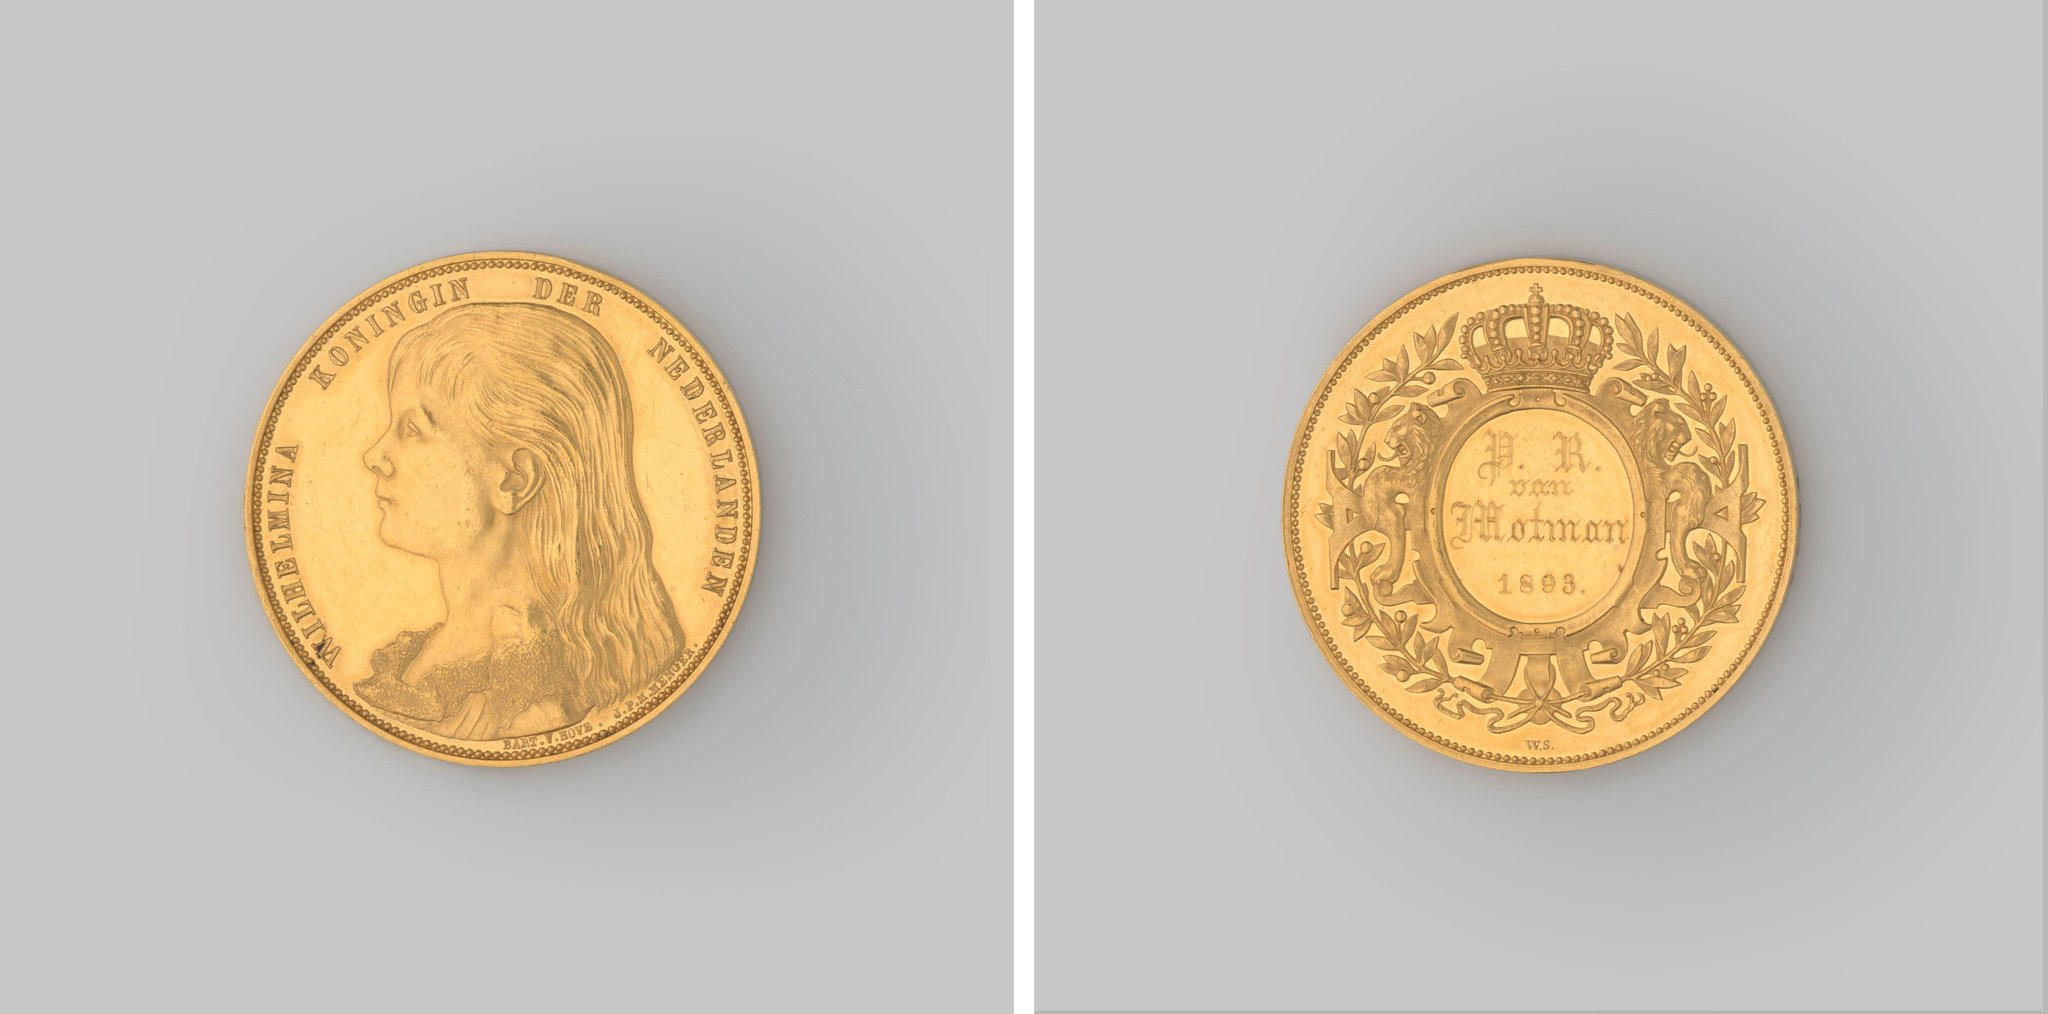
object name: medal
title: Honorary Medal of Queen Wilhelmina Awarded in 1893 to P.R. van Motman for Winning a Horse Race in Batavia, Dutch East Indies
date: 1892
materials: gold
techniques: engraving, striking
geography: netherlands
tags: the hague, print maker, wilhelmina of the netherlands, batavia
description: The Rijksmuseum’s medal collection, boasting some 12,500 objects, is almost a century and a half old. The museum continues to expand its collection with special medals, which are either purchased, donated, or given on loan. On display here are a number of the most extraordinary acquisitions of recent years. These are honorary and commemorative medals. Several are unique and came from the descendants of the individuals who once received them.